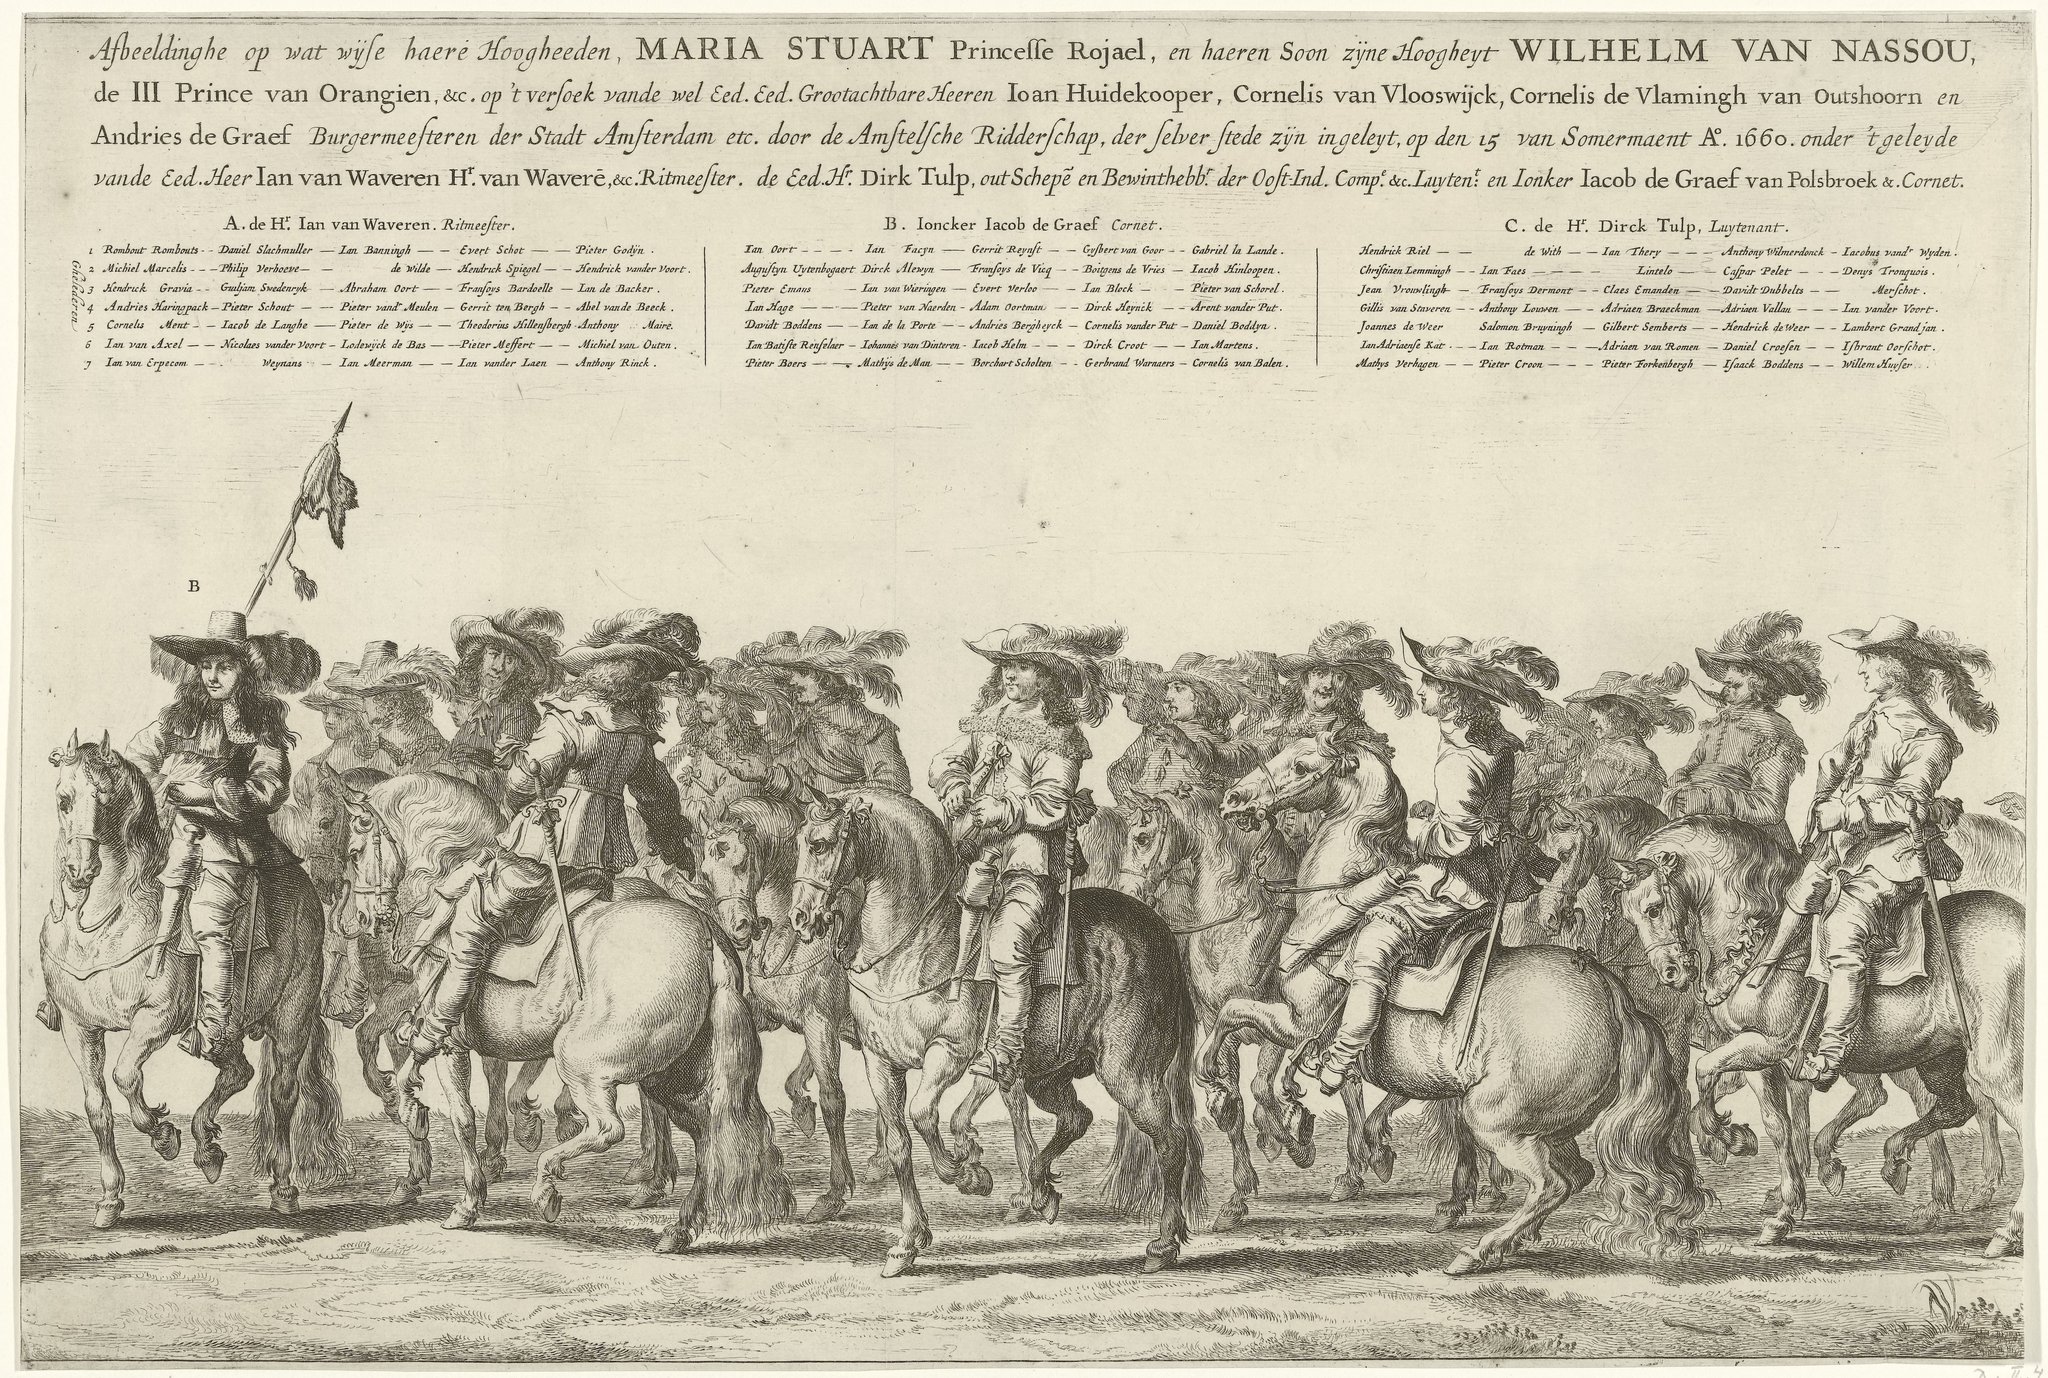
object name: print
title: Intocht van Maria Henrietta Stuart, prinses van Oranje te Amsterdam (plaat 4)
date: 1660-1662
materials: paper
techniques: engraving, etching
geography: northern netherlands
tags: triumphal entry and public reception, pageant, 'entrée solennelle', 'joyeuse entrée'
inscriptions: collector's mark: Lugt 2228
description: Bezoek van Maria Henrietta Stuart, prinses van Oranje, vergezeld door Amalia van Solms, de jonge prins Willem III en anderen te Amsterdam, 15 juni 1660. Blad met een deel van de stoet met ruiters. De voorste ruiter gemerkt met de letter B is jonkheer Jacob de Graef. Bovenaan de titel en de lijst van officieren in 3 kolommen. Vierde plaat in een ongemonteerd ensemble van de stoet bestaande uit zeven bladen.